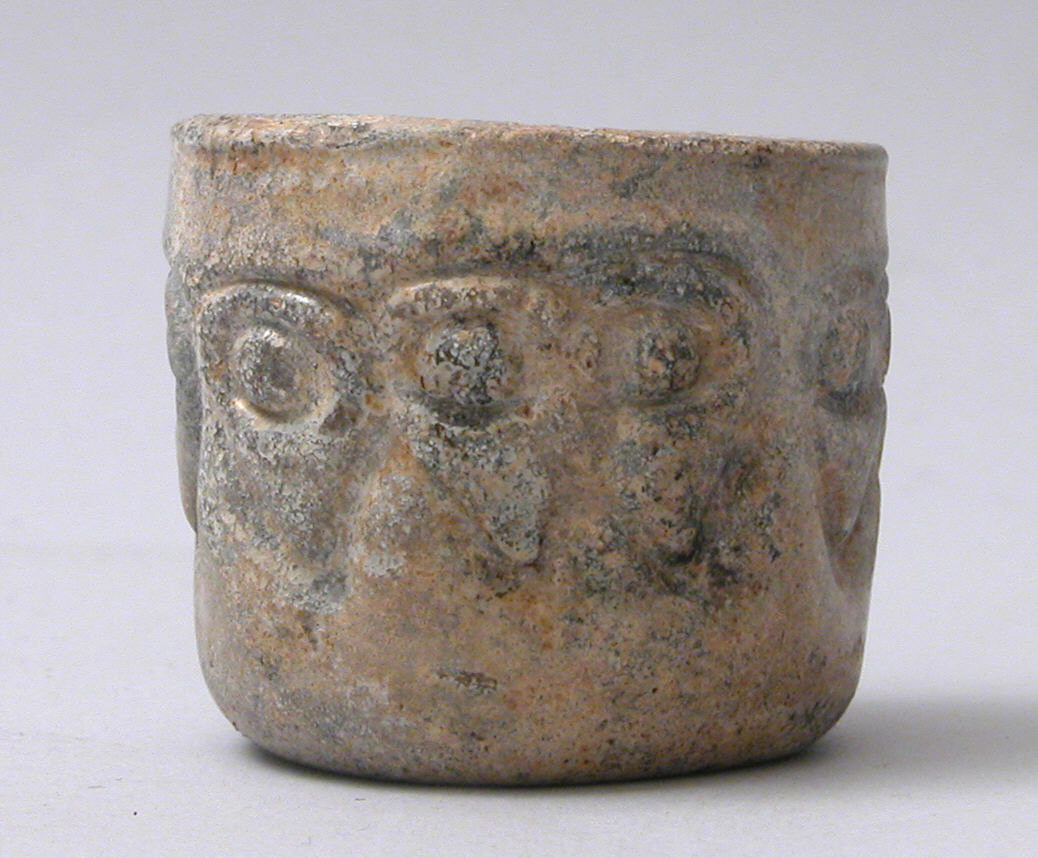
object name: cup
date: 801-1000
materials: glass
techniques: glassblowing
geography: egypt or syria